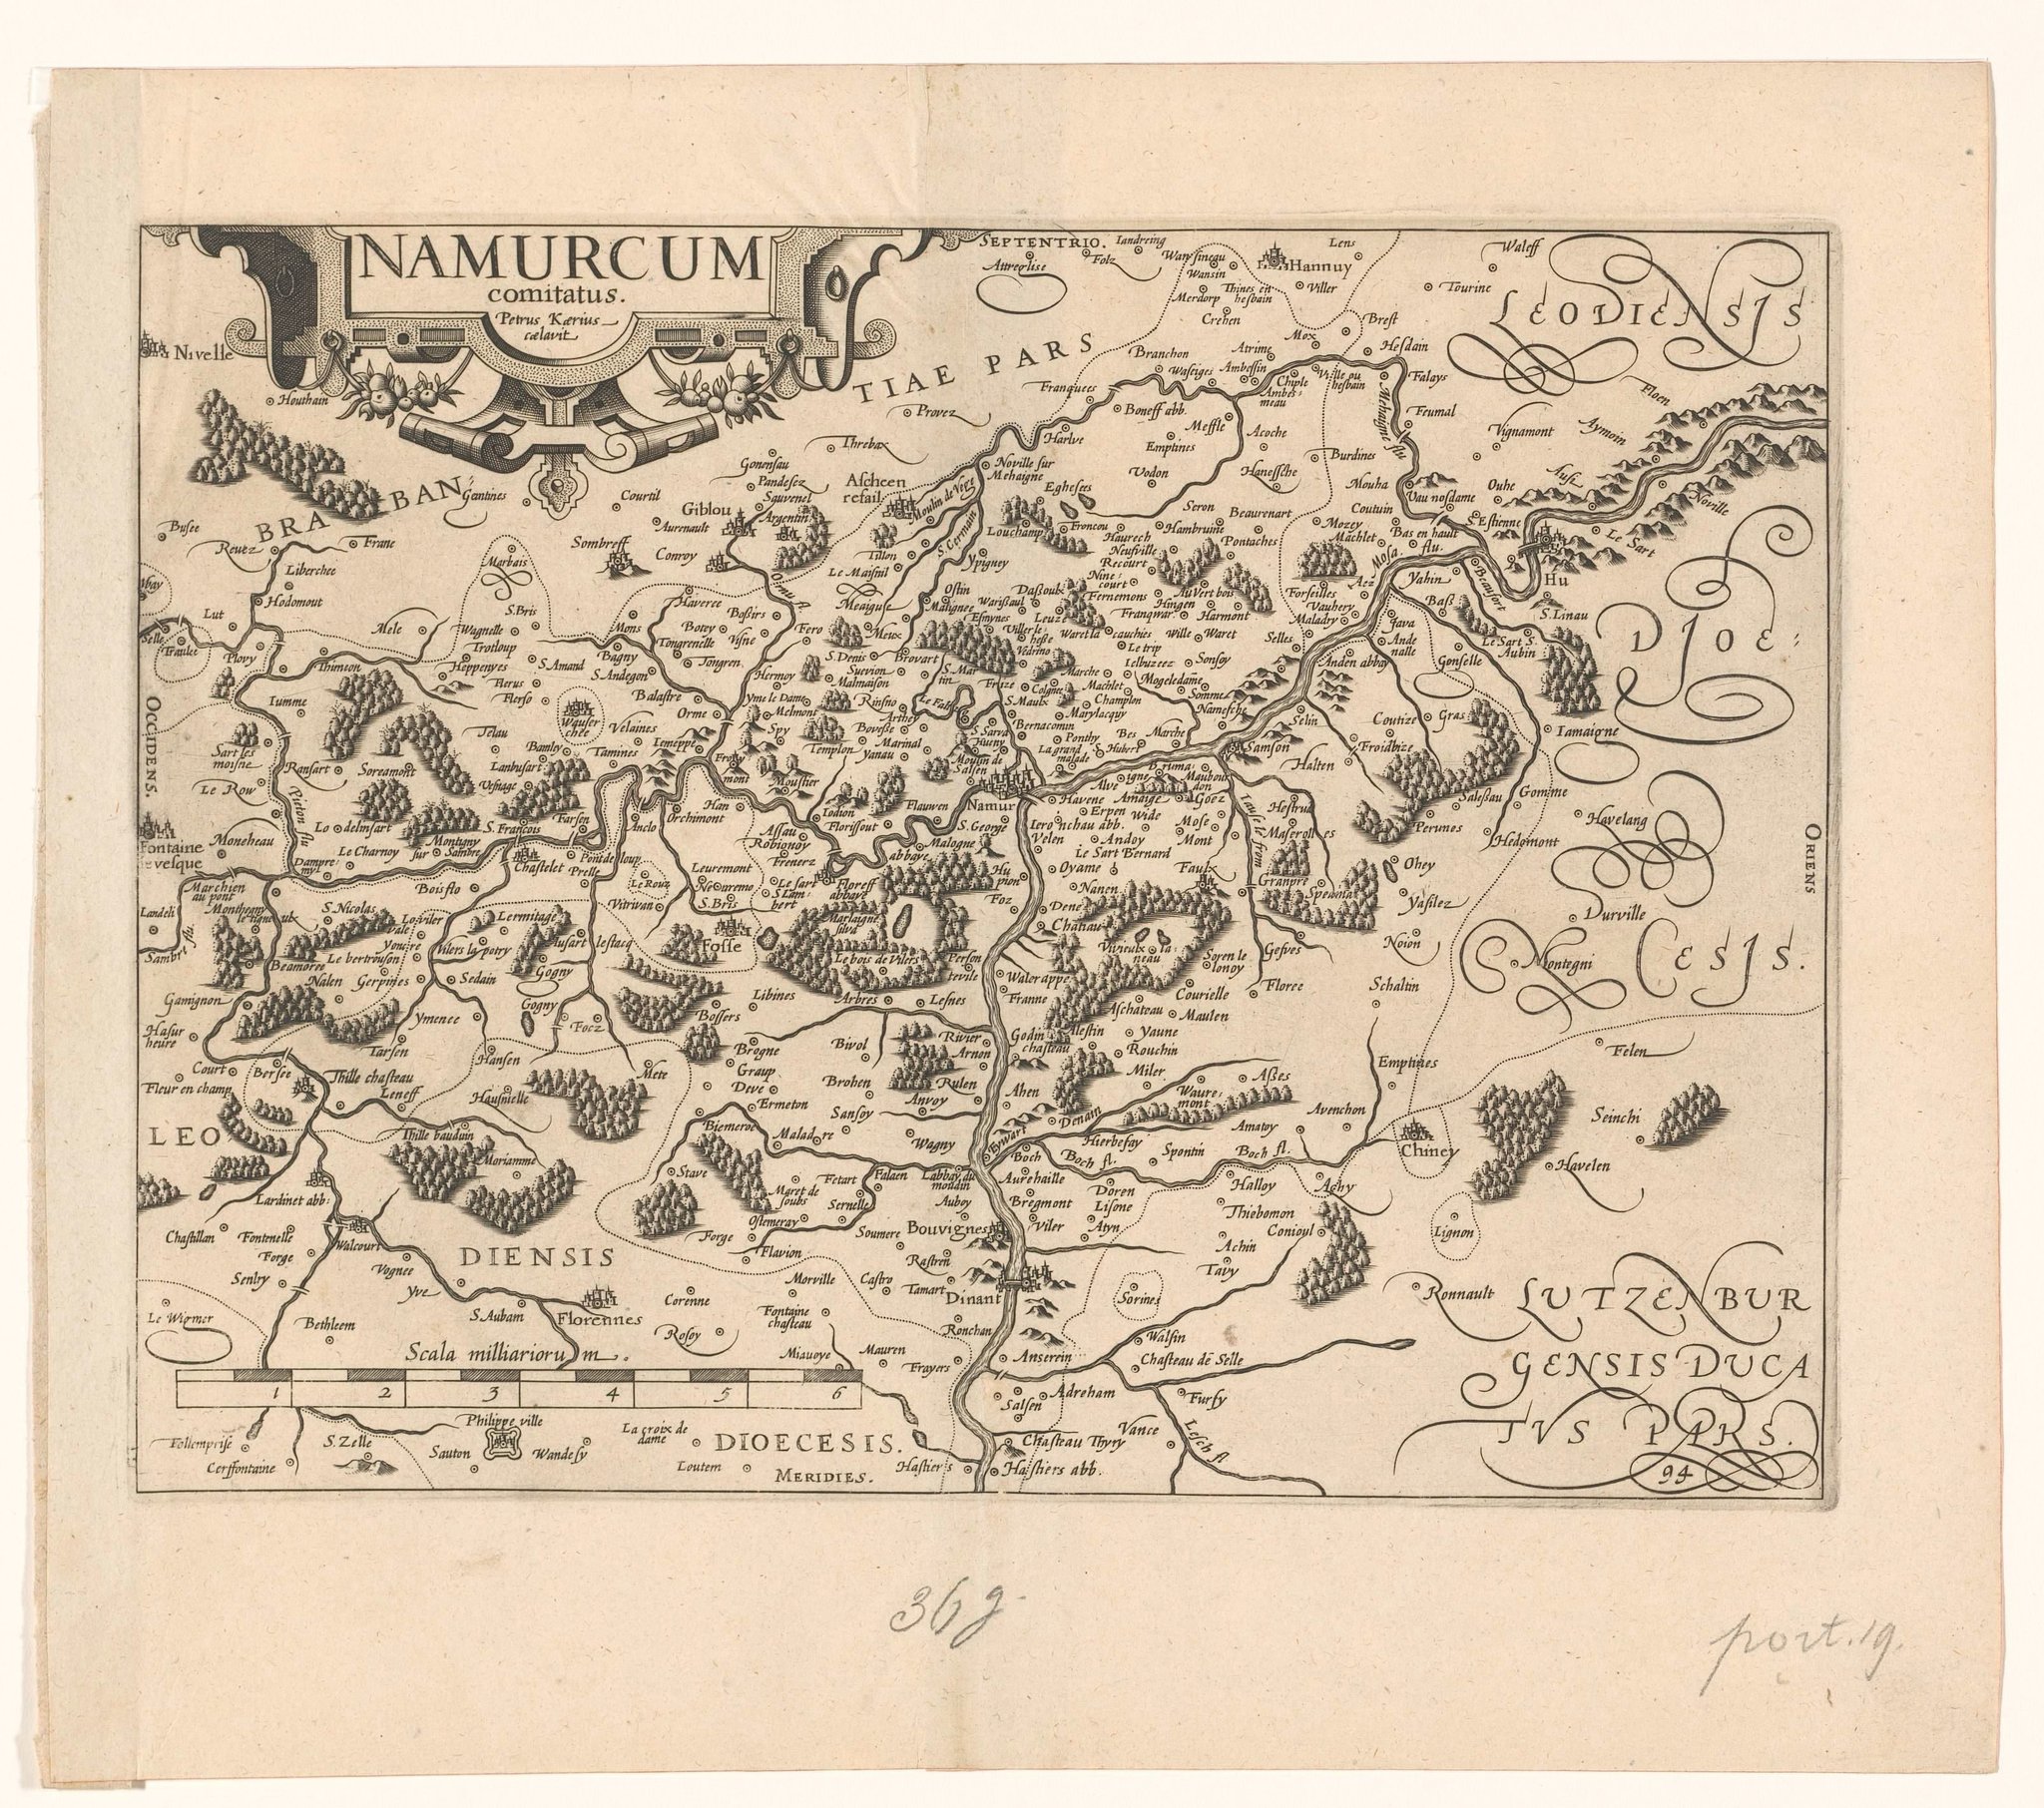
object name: book illustration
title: Kaart van het graafschap Namen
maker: pieter van der keere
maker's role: print maker, publisher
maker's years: 1571-1646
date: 1612-1648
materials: paper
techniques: engraving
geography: amsterdam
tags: maps of separate countries or regions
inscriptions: collector's mark: Lugt 2228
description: Deze staat van prent voor het eerst ook gebruikt in: Guicciardini, Lodovico. Beschryvinghe van alle de Neder-landen, anderssins ghenoemt Neder-Duytslandt (…). Amsterdam: Willem Janszoon Blaeu, 1612. Hierna is deze prent tot 1648 nog gebruikt in latere uitgaven van deze publicatie, uitgegeven door Blaeu en daarna door Janssonius. Uit welke uitgave het huidige exemplaar precies komt is niet na te gaan.